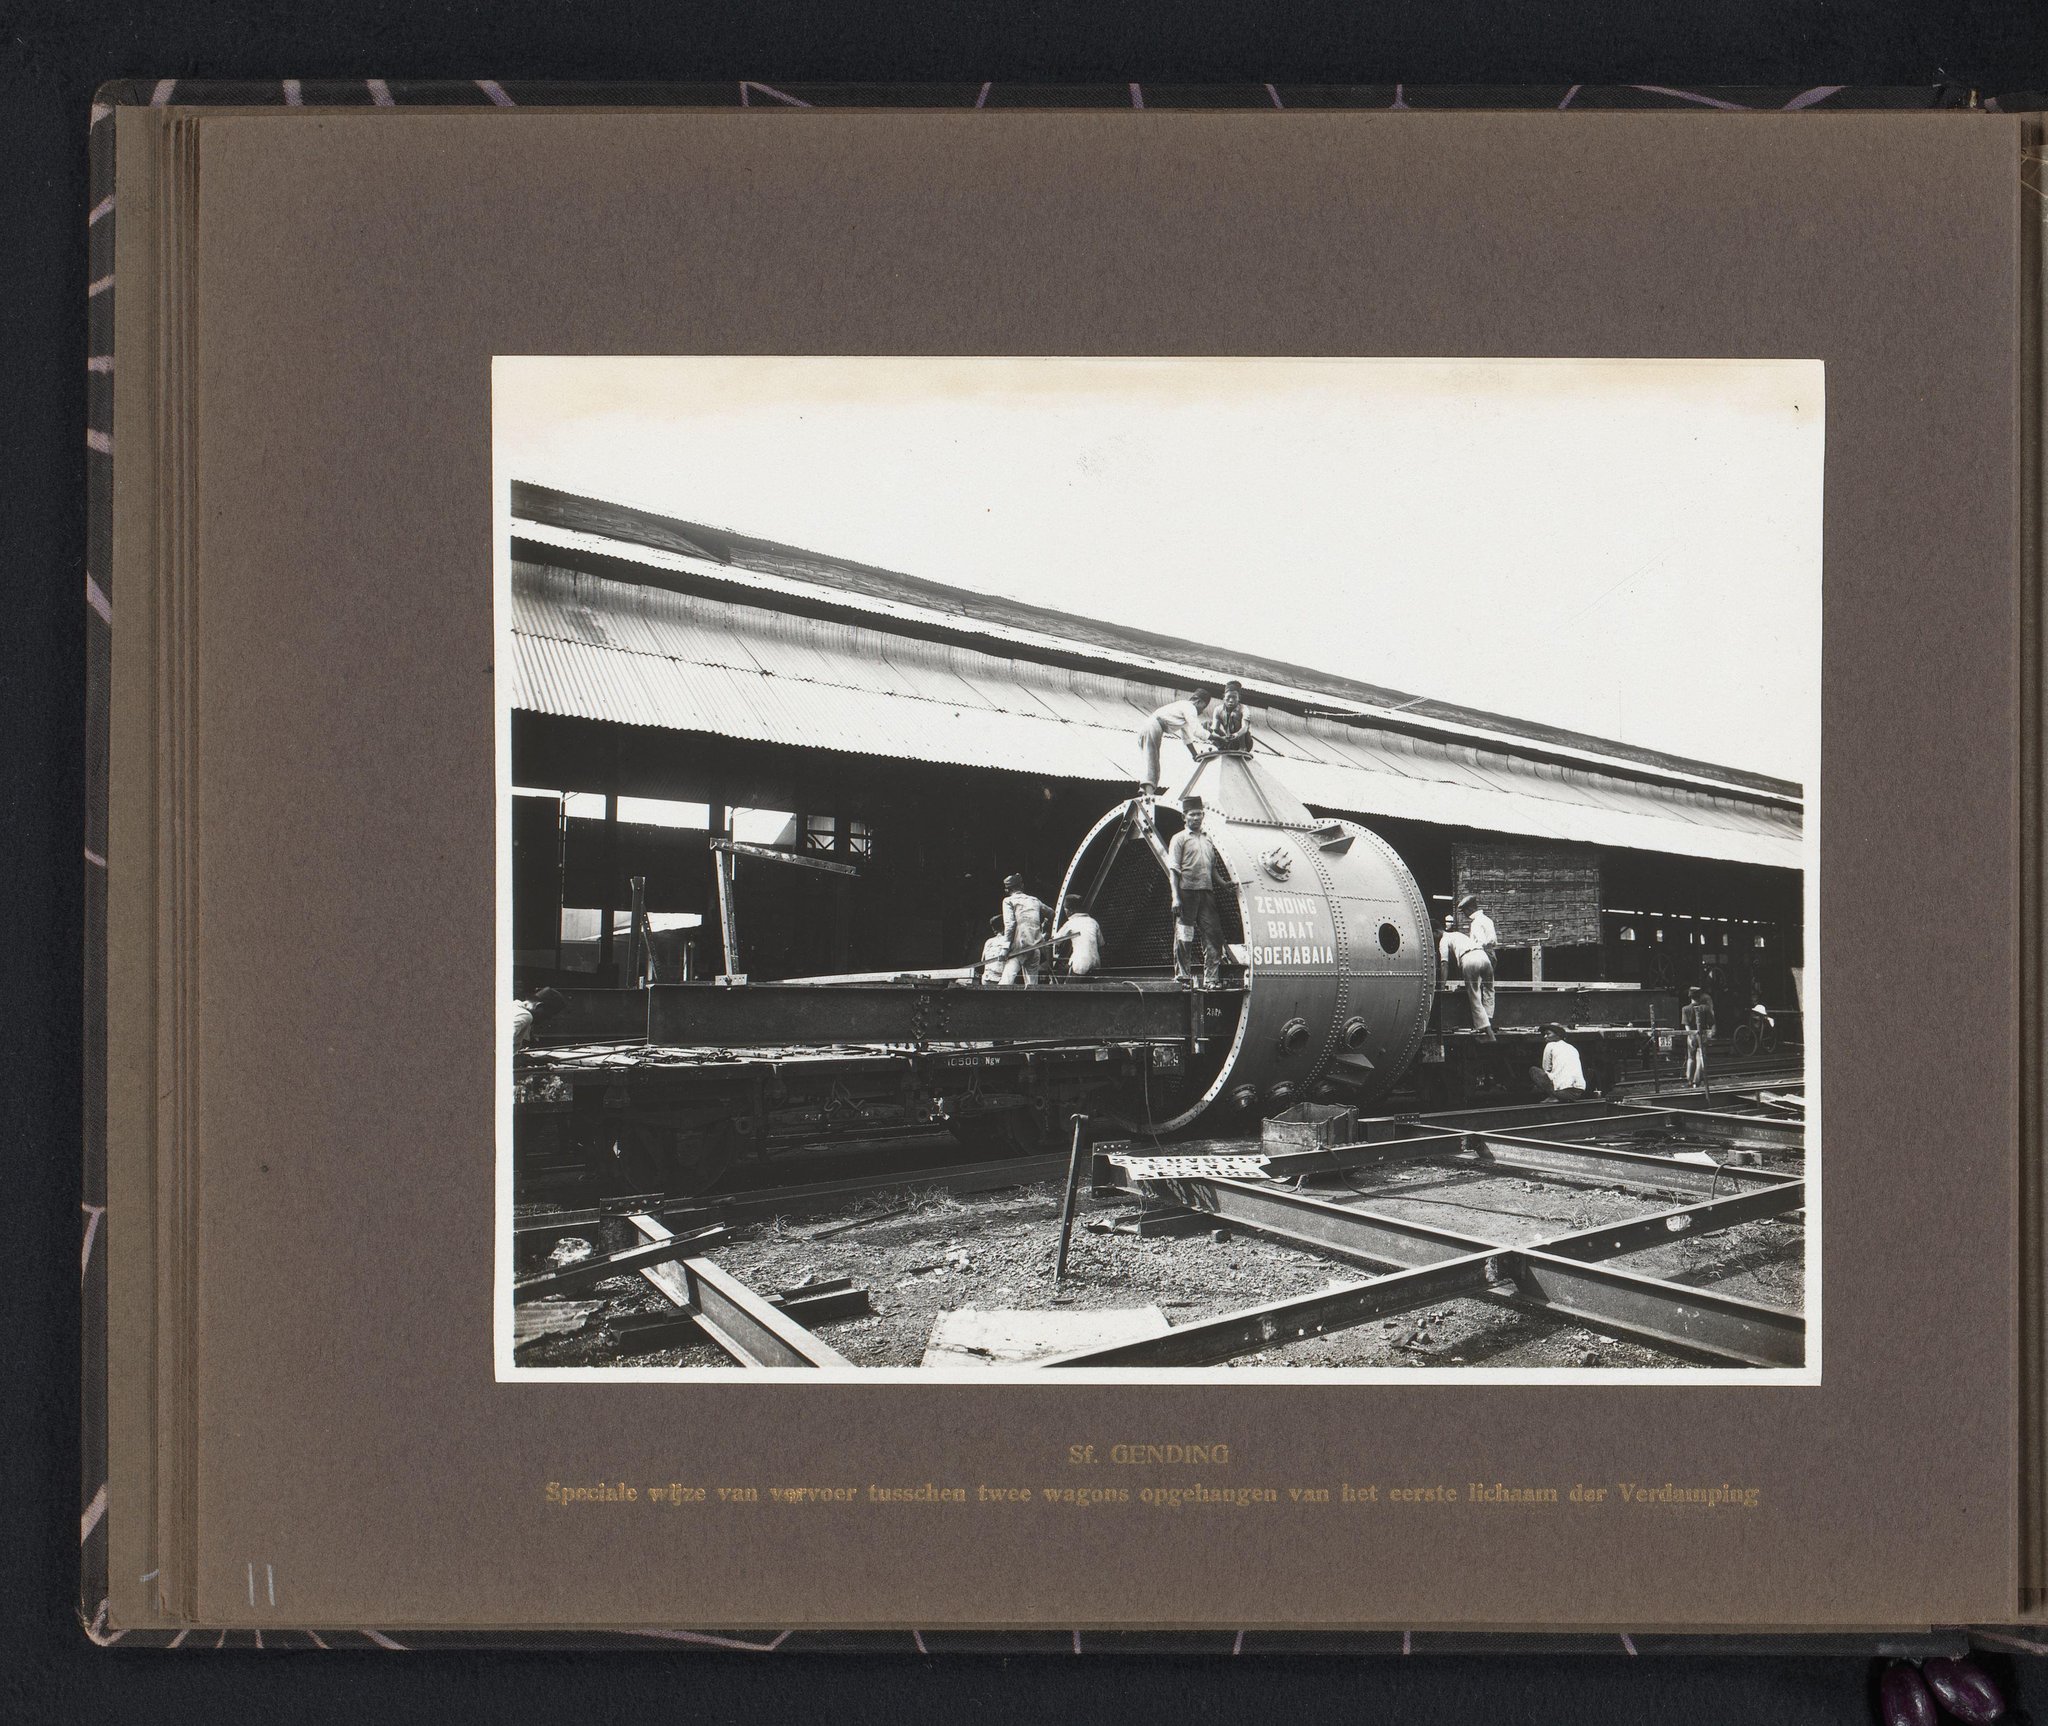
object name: album leaf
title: Sf. Gending / Speciale wijze van vervoer tusschen twee wagons opgehangen van het eerste lichaam der Verdamping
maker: Anonymous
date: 1916-1924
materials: cardboard, photographic support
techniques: gelatin silver print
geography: surabaya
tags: colonial system, freight train, machines; parts of machines; tools and appliances, java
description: Albumblad met een foto van de voorbereiding voor het transport per spoor van een verdampingslichaam. Vervaardigd door Machinefabriek Braat in Soerabaja en bestemd voor de Suikerfabriek Gending. Onderdeel van het fotoalbum Machinefabriek Braat Soerabaia-Djocja-Tegal, ca. 1916-1924.